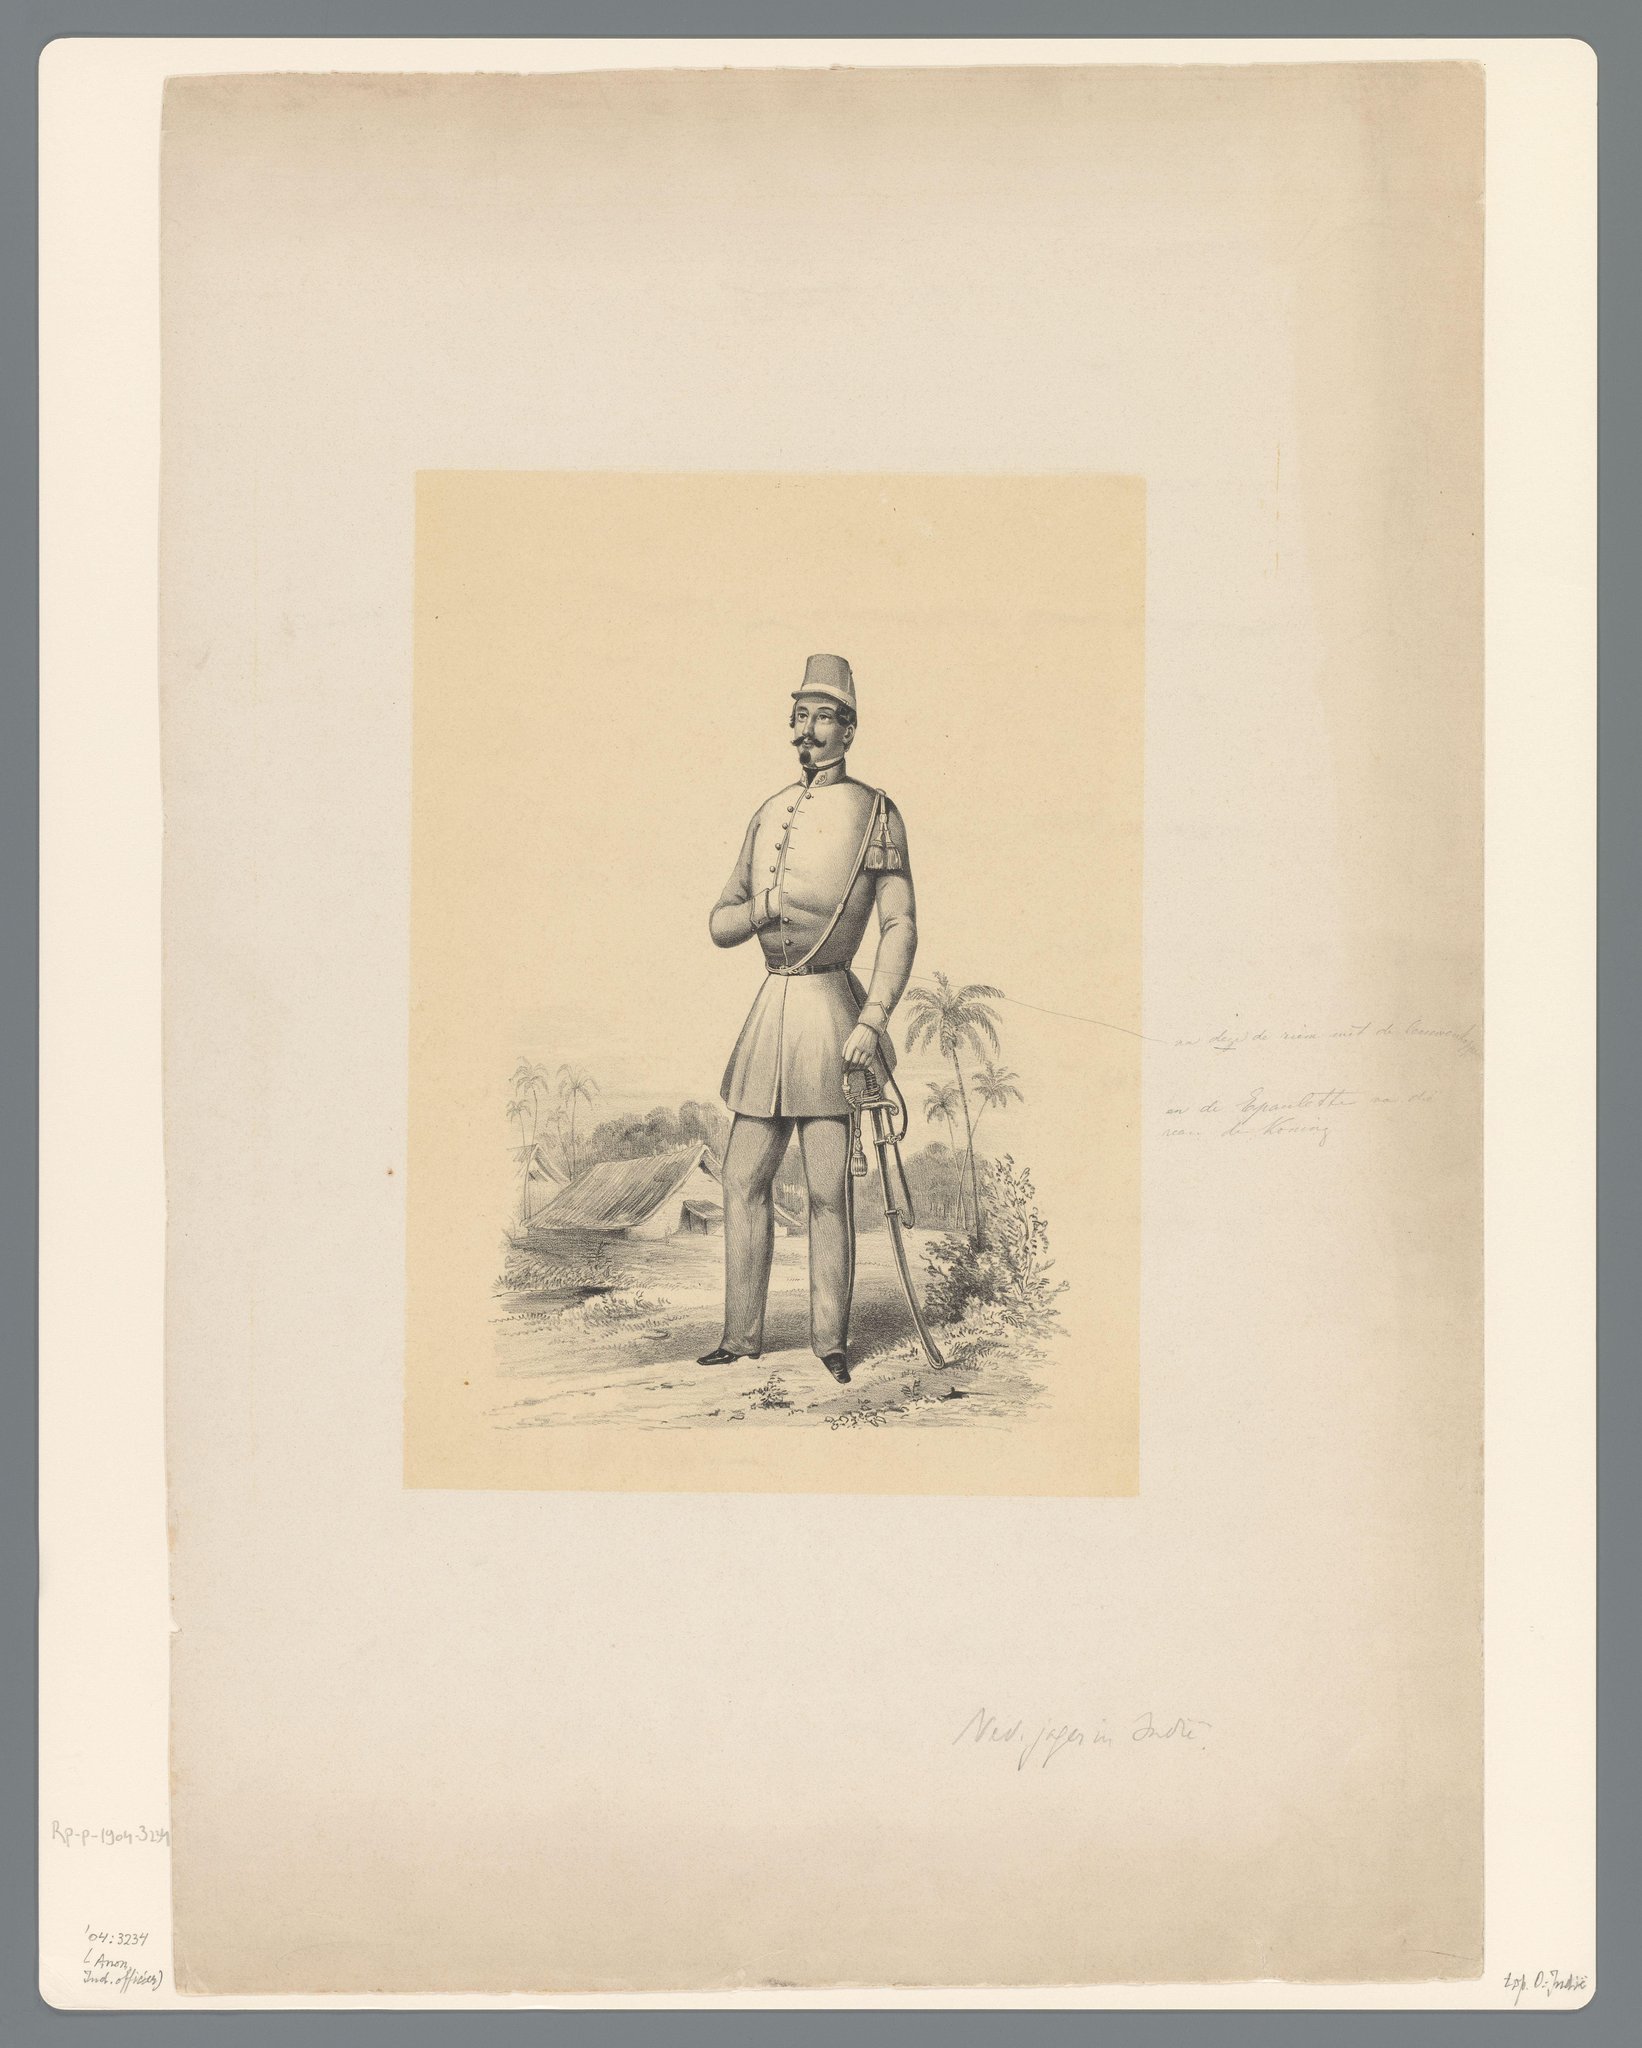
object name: print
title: Eerste luitenant van het Koninklijk Nederlandsch-Indisch Leger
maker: Anonymous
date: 1814-1850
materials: paper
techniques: lithograph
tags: officer, dutch east indies, the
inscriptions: collector's mark: Lugt 2228